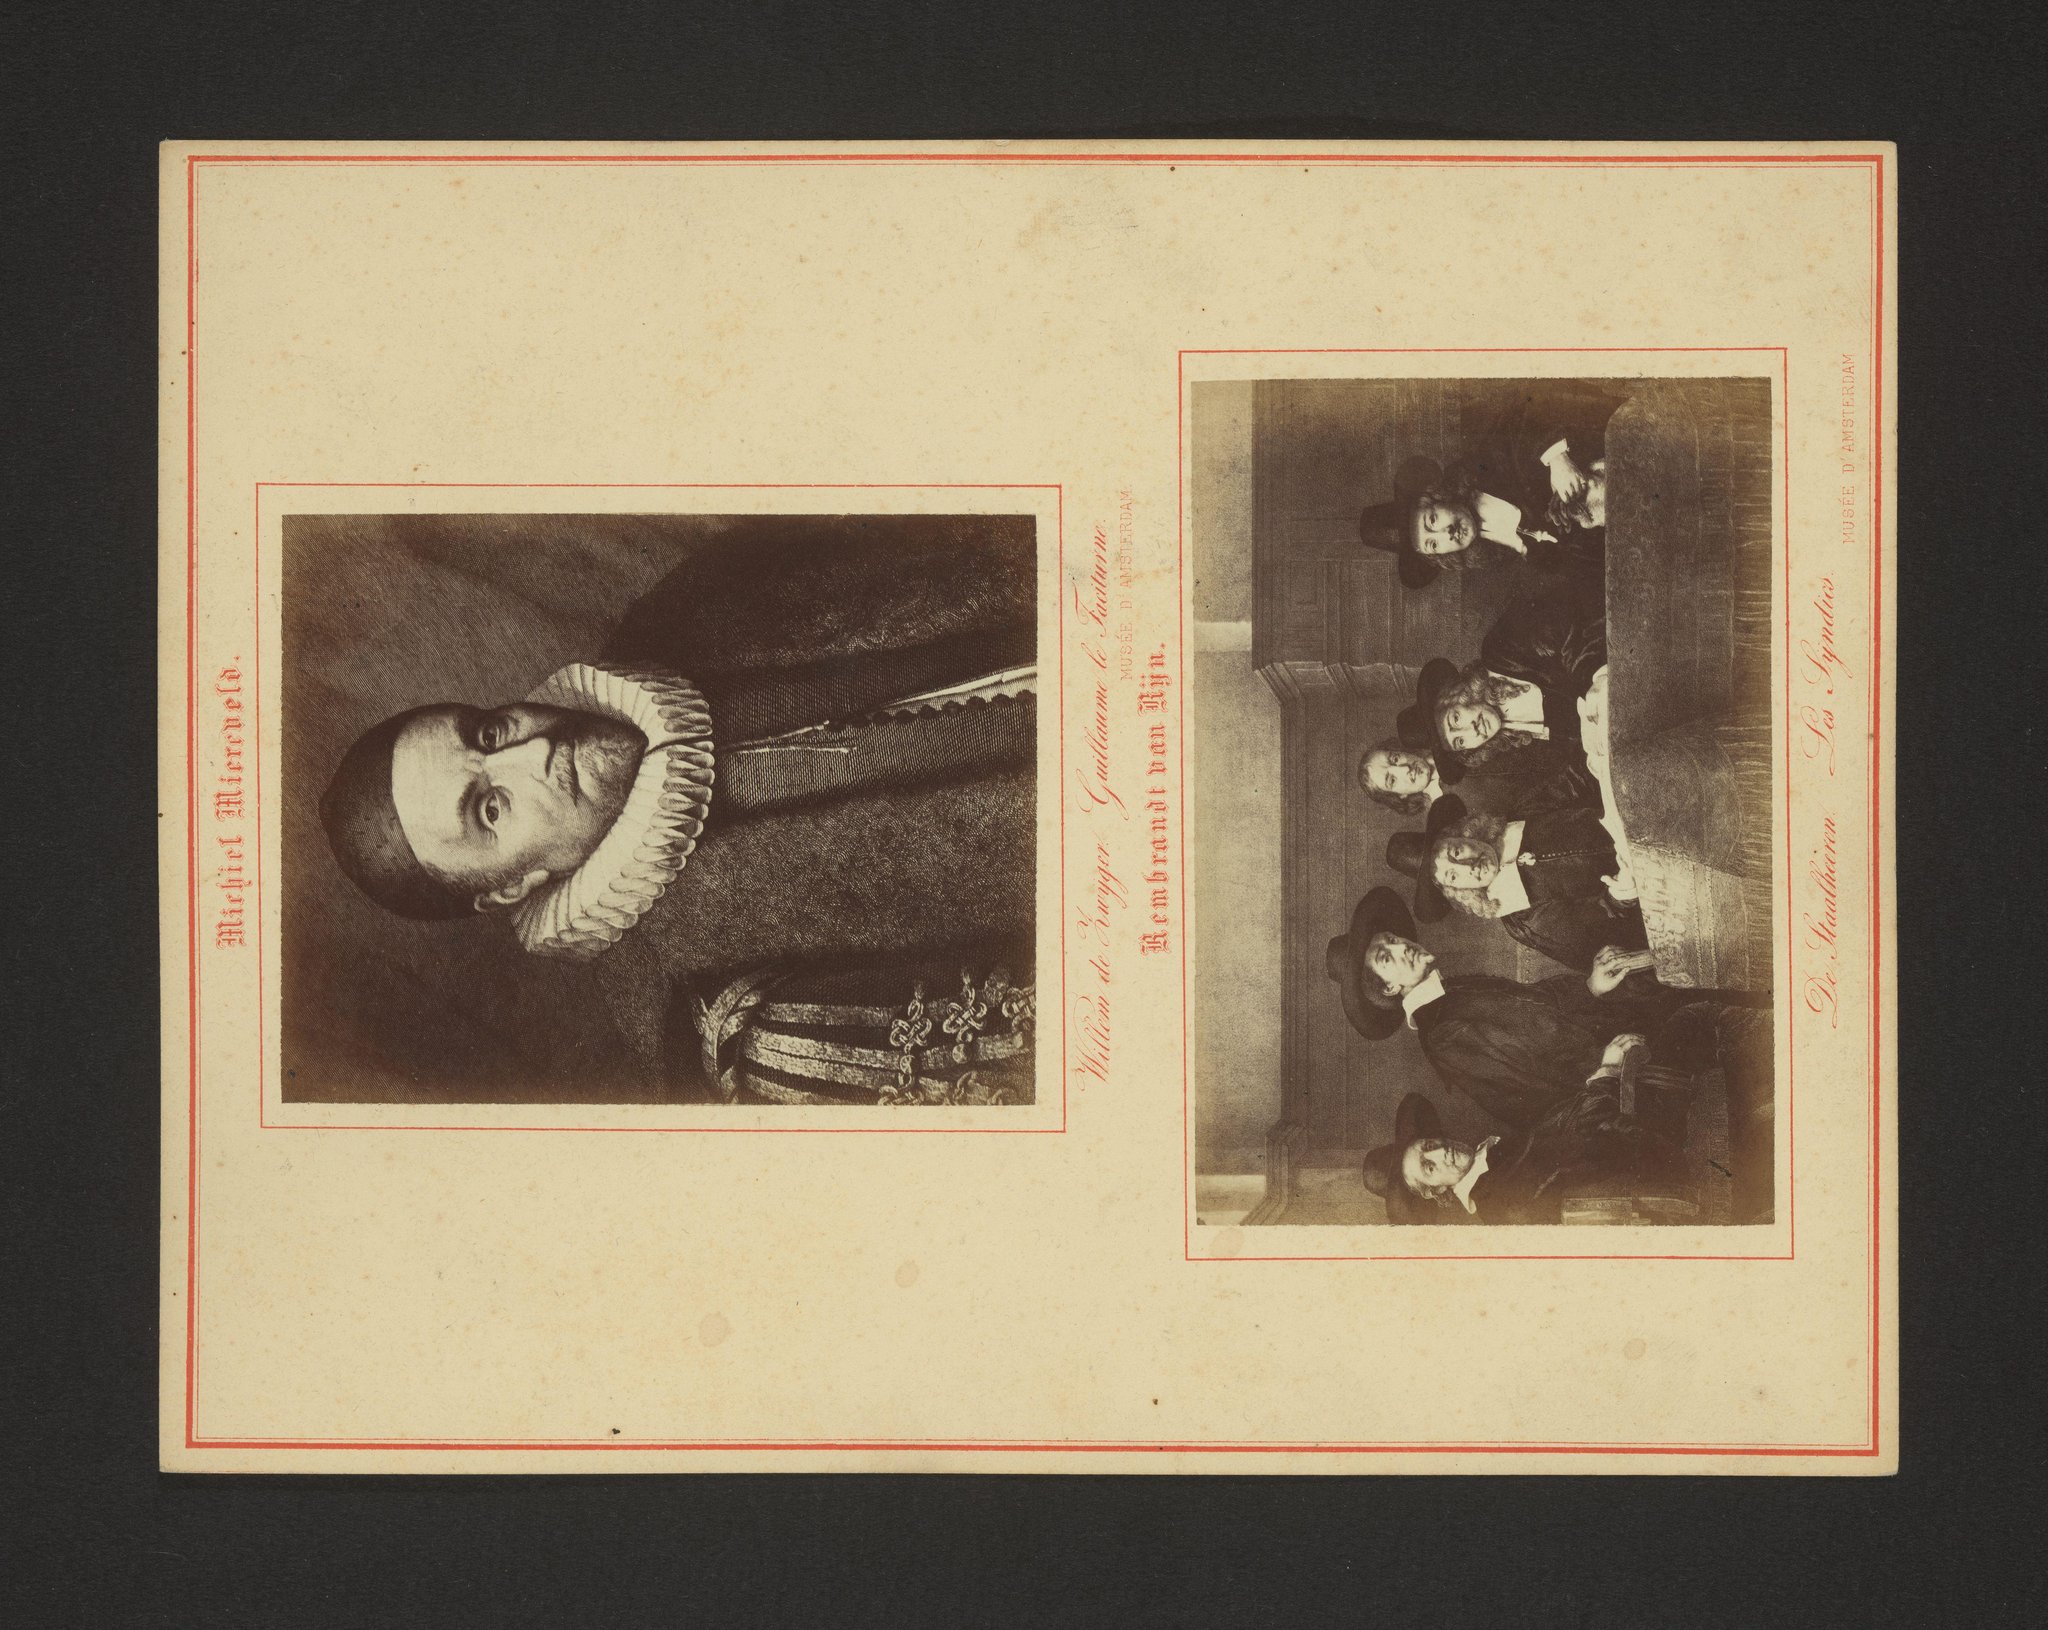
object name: reproduction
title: Rembrandt van Rijn - De Staalheren, Les Syndics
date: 1866-1874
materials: cardboard, photographic support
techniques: albumen print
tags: delft, william i (prince of orange), historical persons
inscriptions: annotation: ‘Musée d'Amsterdam’, annotation: ‘Musée d'Amsterdam’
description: Deze foto maakt deel uit van een omslag met 25 foto's.